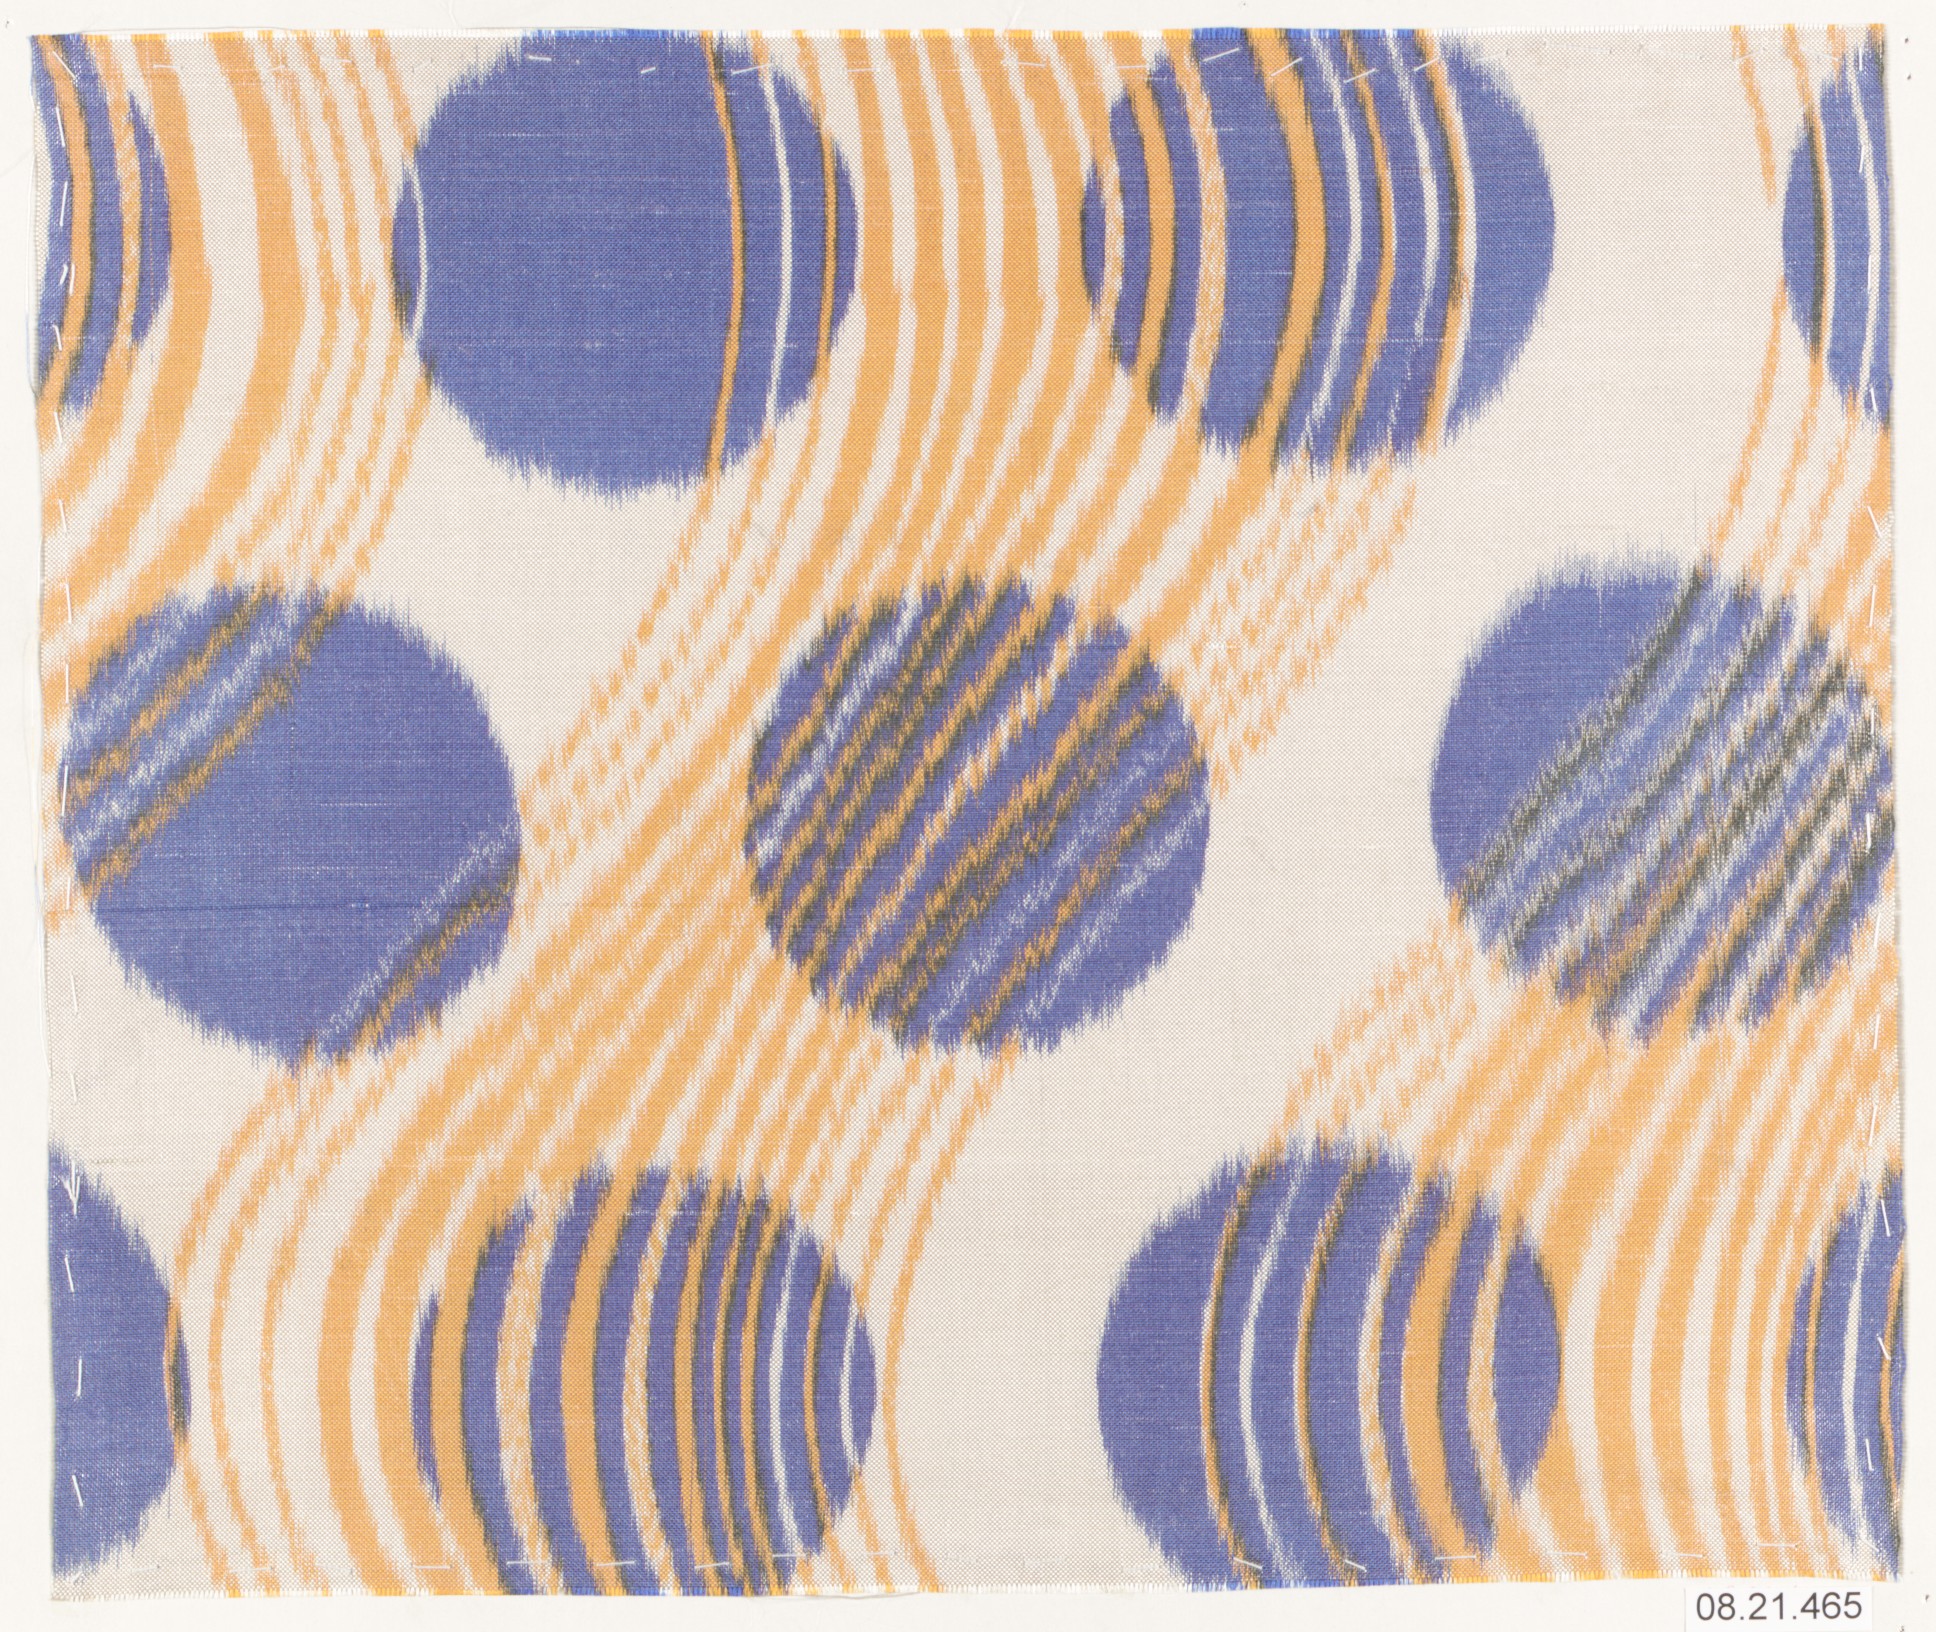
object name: textile sample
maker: Anonymous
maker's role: designer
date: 1900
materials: silk